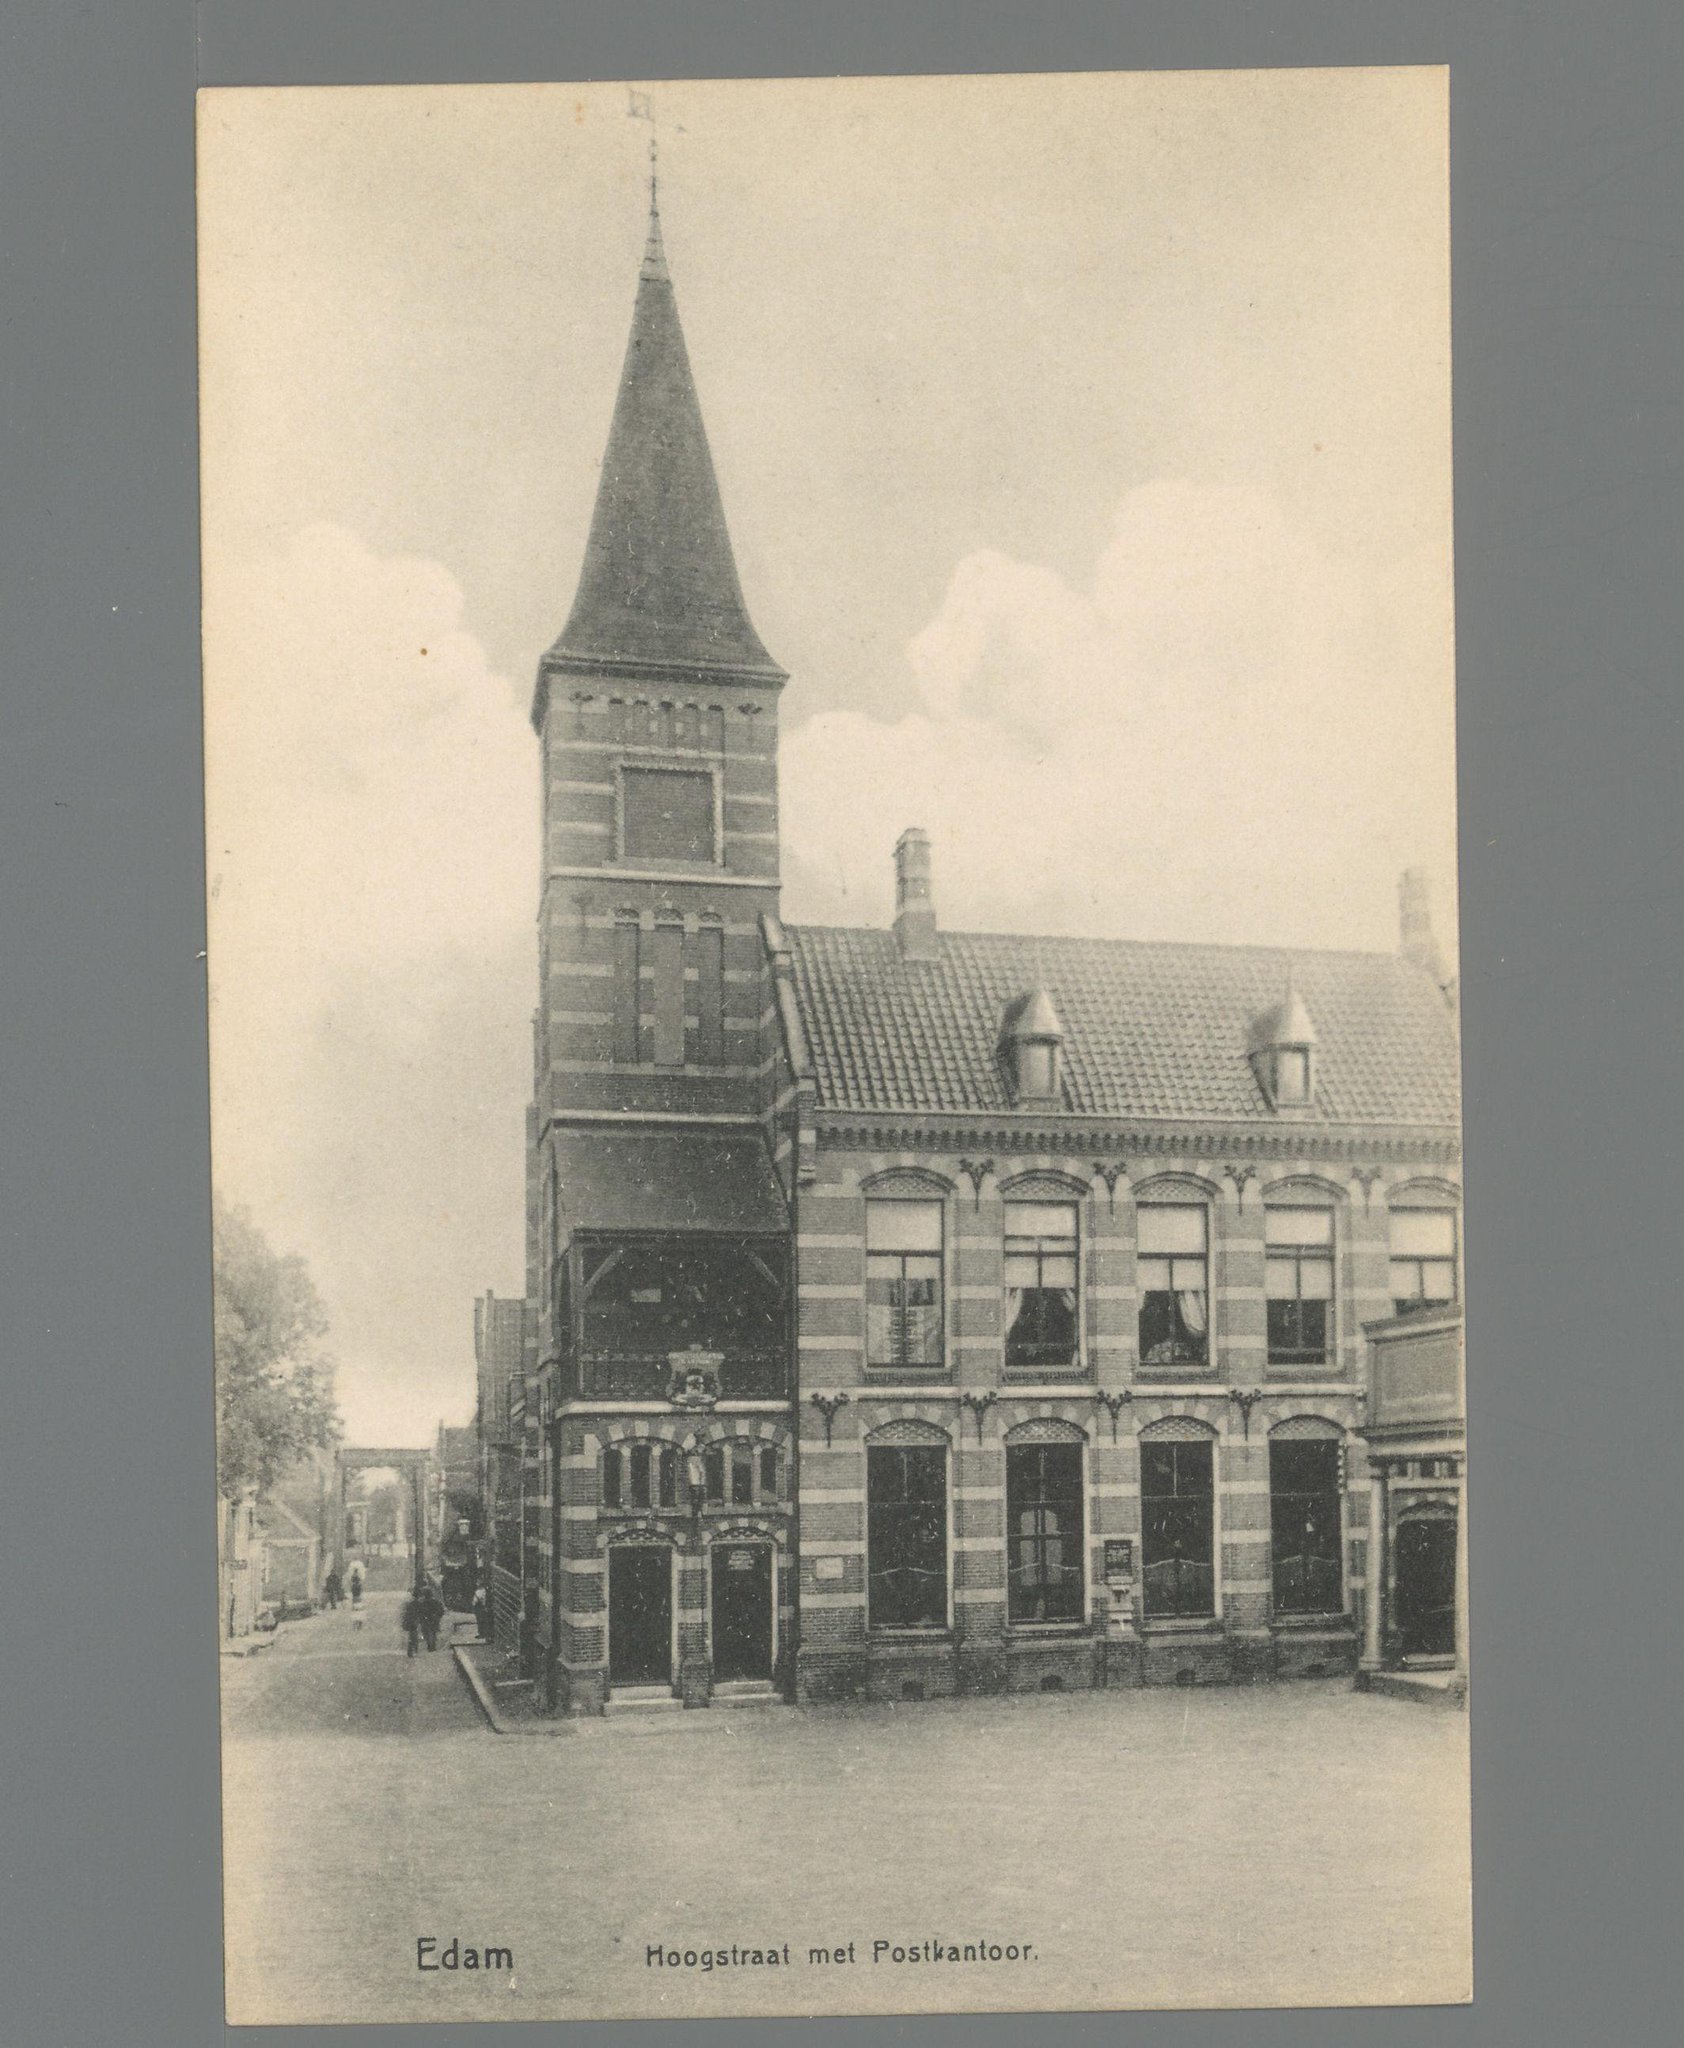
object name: ansichtkaart, prentbriefkaart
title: Edam. Hoogstraat met postkantoor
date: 1906-1930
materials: cardboard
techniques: photograph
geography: edam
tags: city-view, and landscape with man-made constructions, post-office